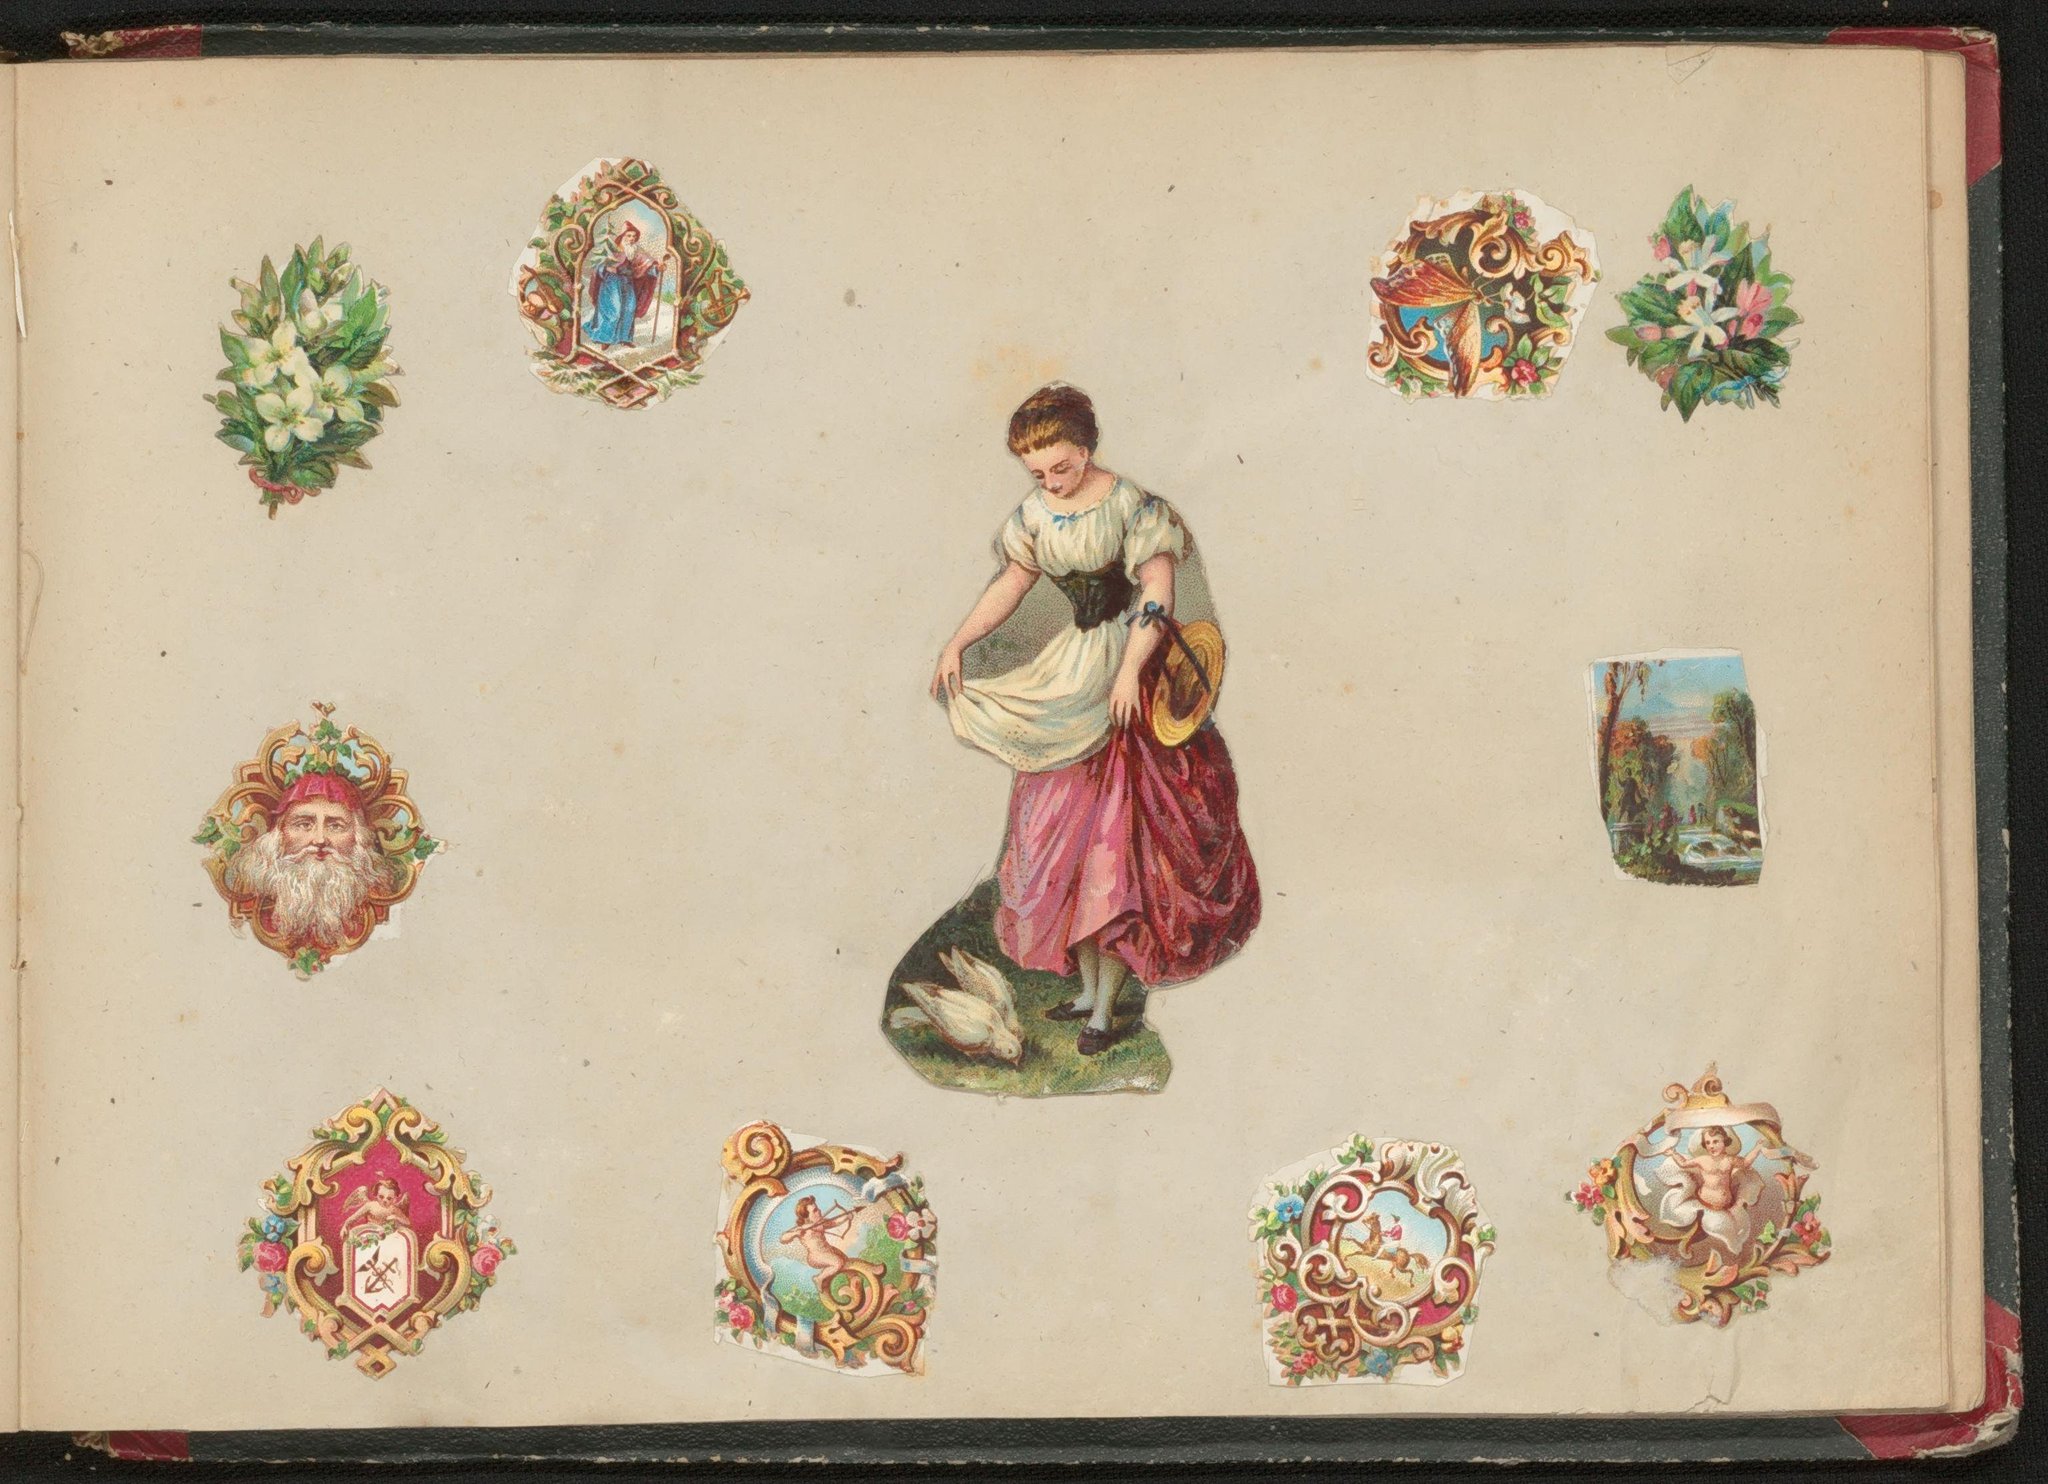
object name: album leaf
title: Albumblad met 11 plakplaatjes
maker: Anonymous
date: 1880-1910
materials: paper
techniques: chromolithography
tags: cut flowers; nosegay, bunch of flowers, ornaments ~ art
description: Albumblad met 11 plakplaatjes van boeketten en cartouches, centraal een vrouw die vanuit haar schort vogels voert. Onderdeel van het plakboek met 38 bladen gevuld met plakplaatjes, poesieplaatjes en uitgeknipte en ingeplakte fragmenten van prenten. Onderwerpsrubrieken binnen de Atlas Zeden en Gewoonten: Schoone kunsten, Varia.